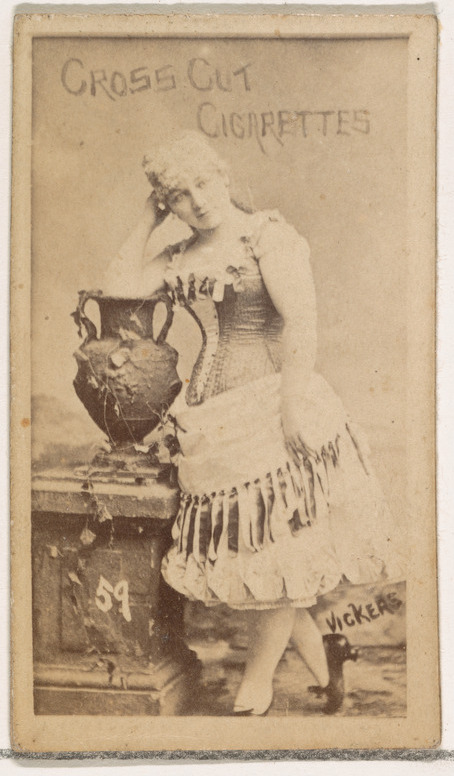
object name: print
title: Card Number 59, Vickers, from the Actors and Actresses series (N145-1) issued by Duke Sons & Co. to promote Cross Cut Cigarettes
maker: w. duke, sons & co.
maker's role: publisher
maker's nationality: american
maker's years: 1870-1920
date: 1880-1889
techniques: albumen silver print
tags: portraits,women,actresses